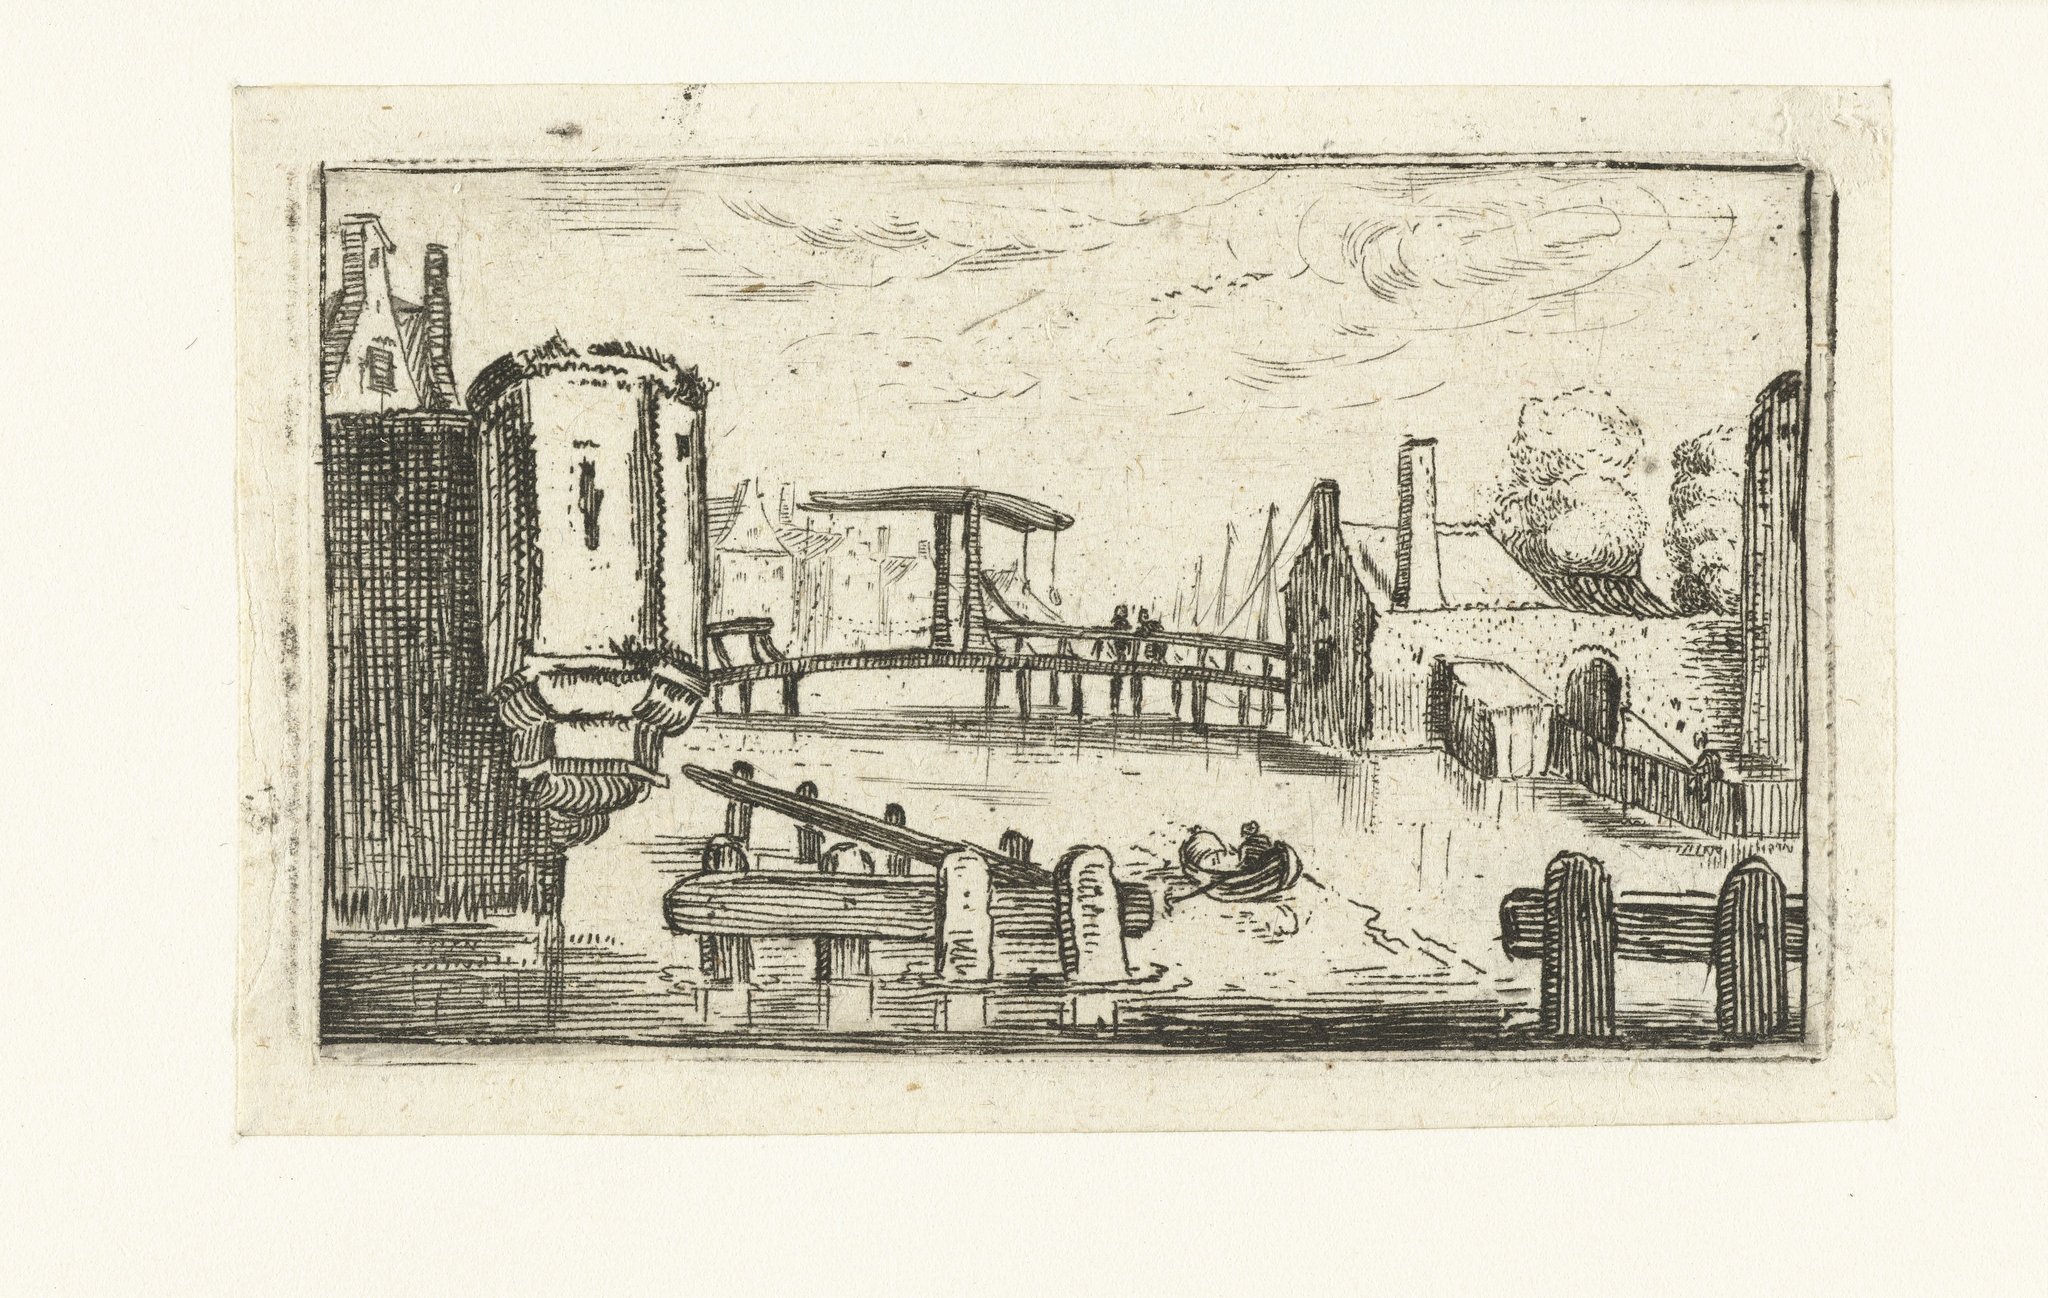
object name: print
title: Kleine landschappen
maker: Anonymous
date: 1613-1680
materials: paper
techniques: engraving, etching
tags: canals, waters (in city)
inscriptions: collector's mark: Lugt 2228a